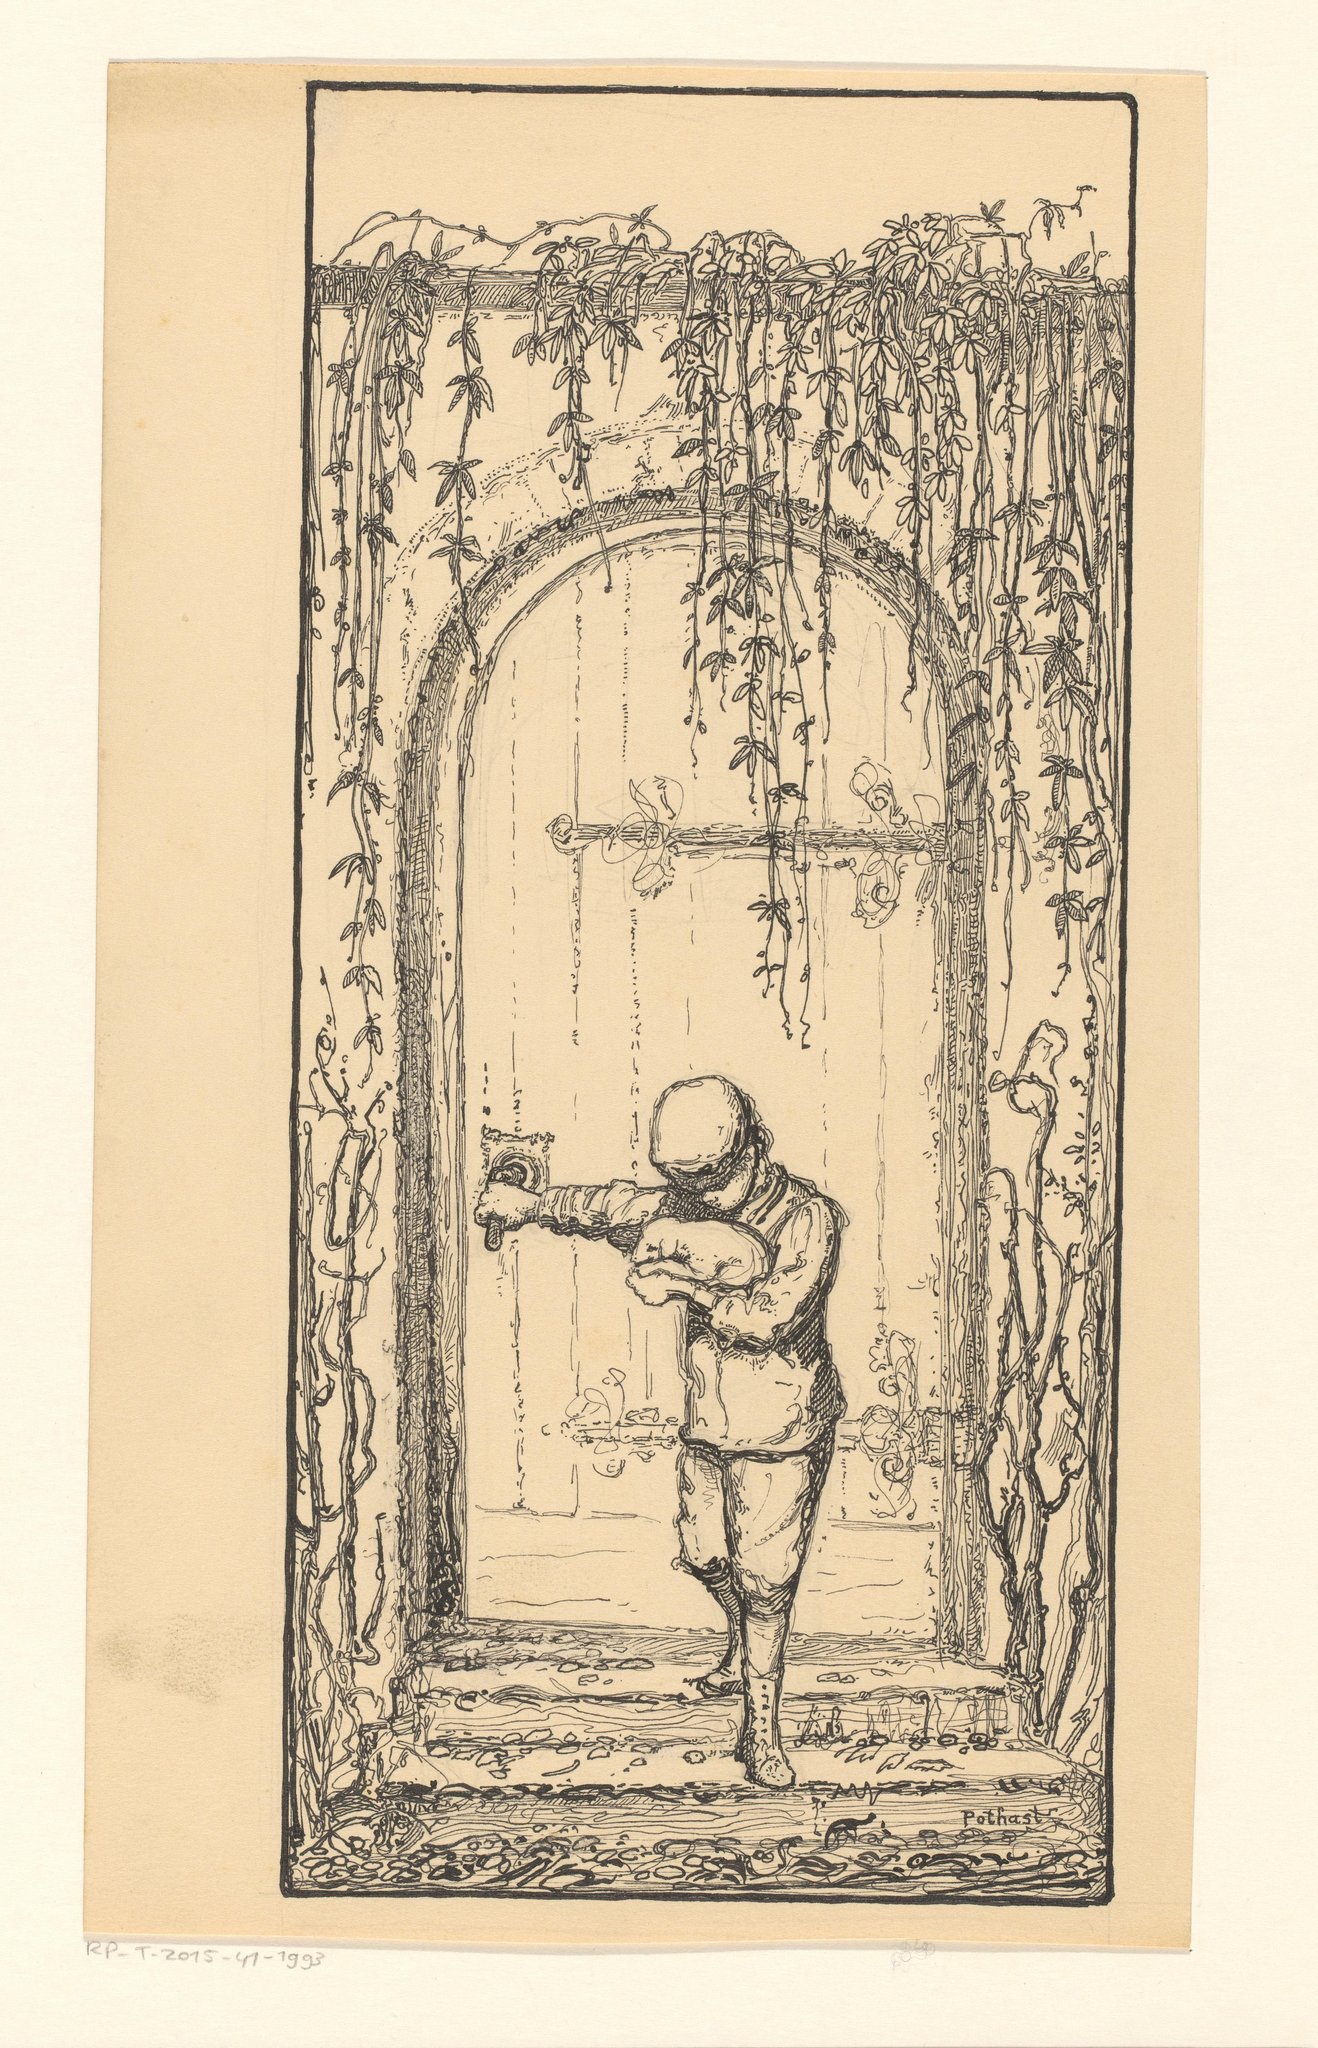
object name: boekillustratie ontwerp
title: Jongen met kat bij een deur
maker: willem pothast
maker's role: draughtsman, print maker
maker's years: 1877-1916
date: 1887-1916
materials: ink, paper, pencil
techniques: pen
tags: plants (in general), cat, boy (child between toddler and youth), closed door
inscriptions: collector's mark: Lugt 2228, signature: ‘Pothast’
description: Een jongen staat met een kat op de arm op de treden voor een deur en houdt zijn rechterhand op de deurklink. Rond de deur groeien klim- en hangplanten.